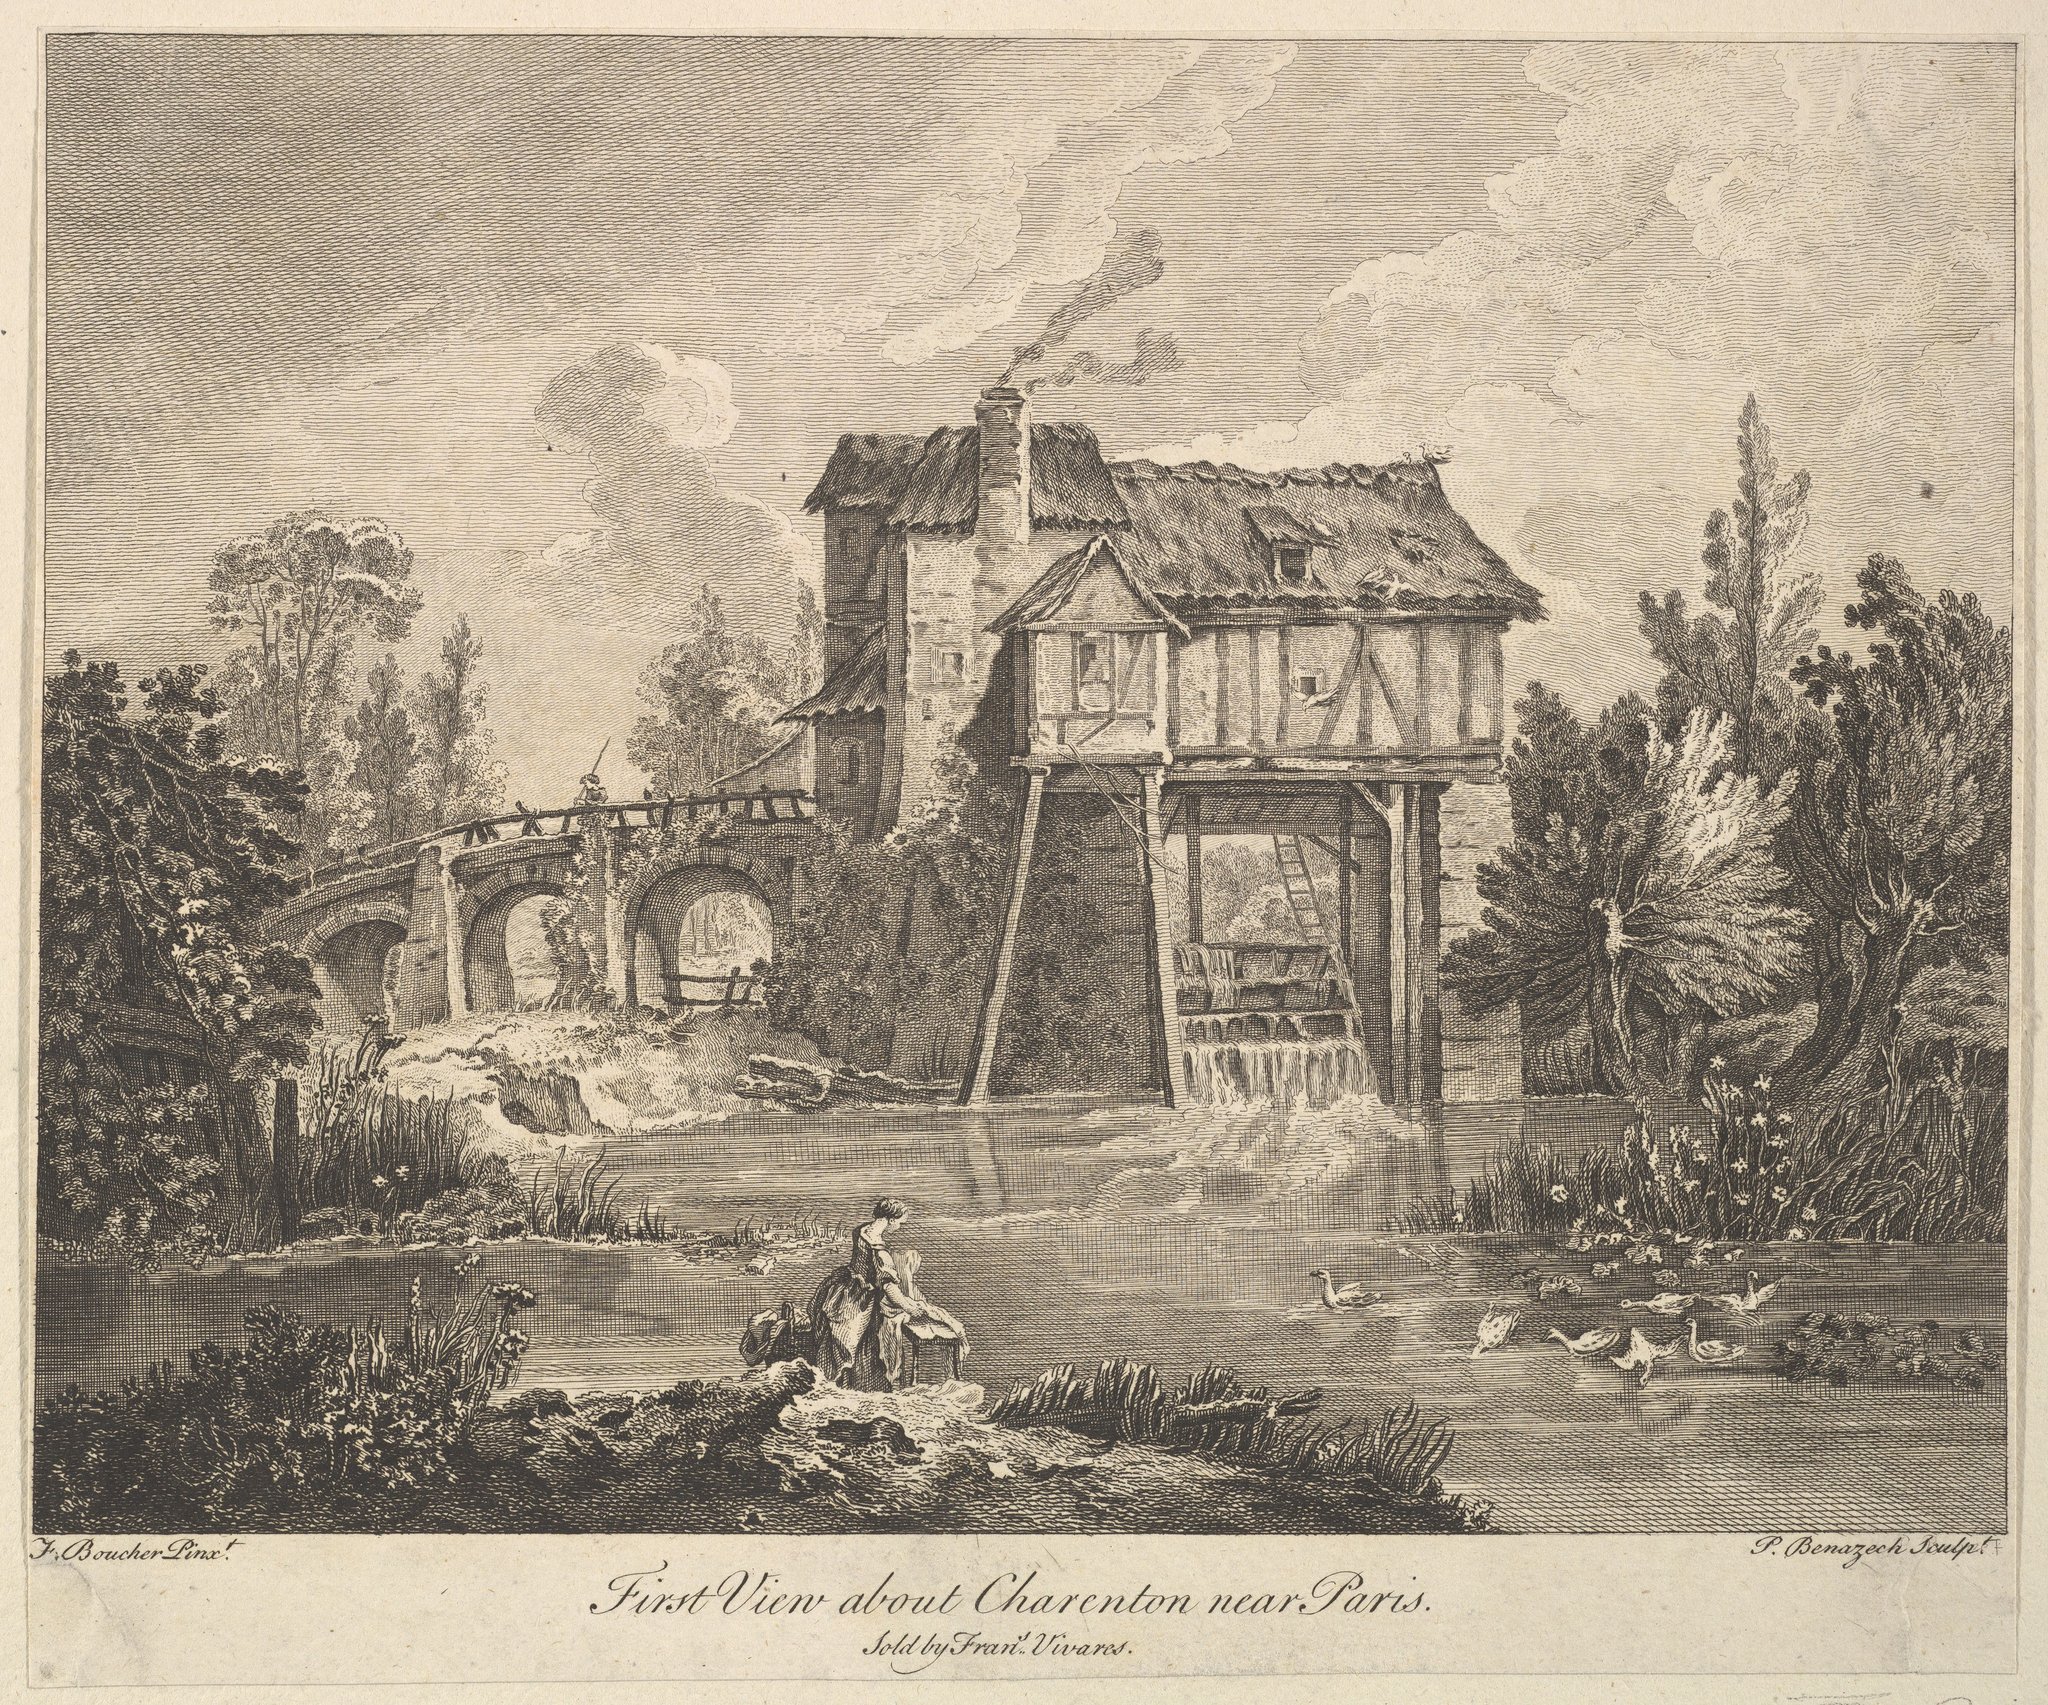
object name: print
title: First View of Clarenton near Paris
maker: peter paul benazech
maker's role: artist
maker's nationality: british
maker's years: 1730-1783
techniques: engraving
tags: birds,watermills,bridges,women